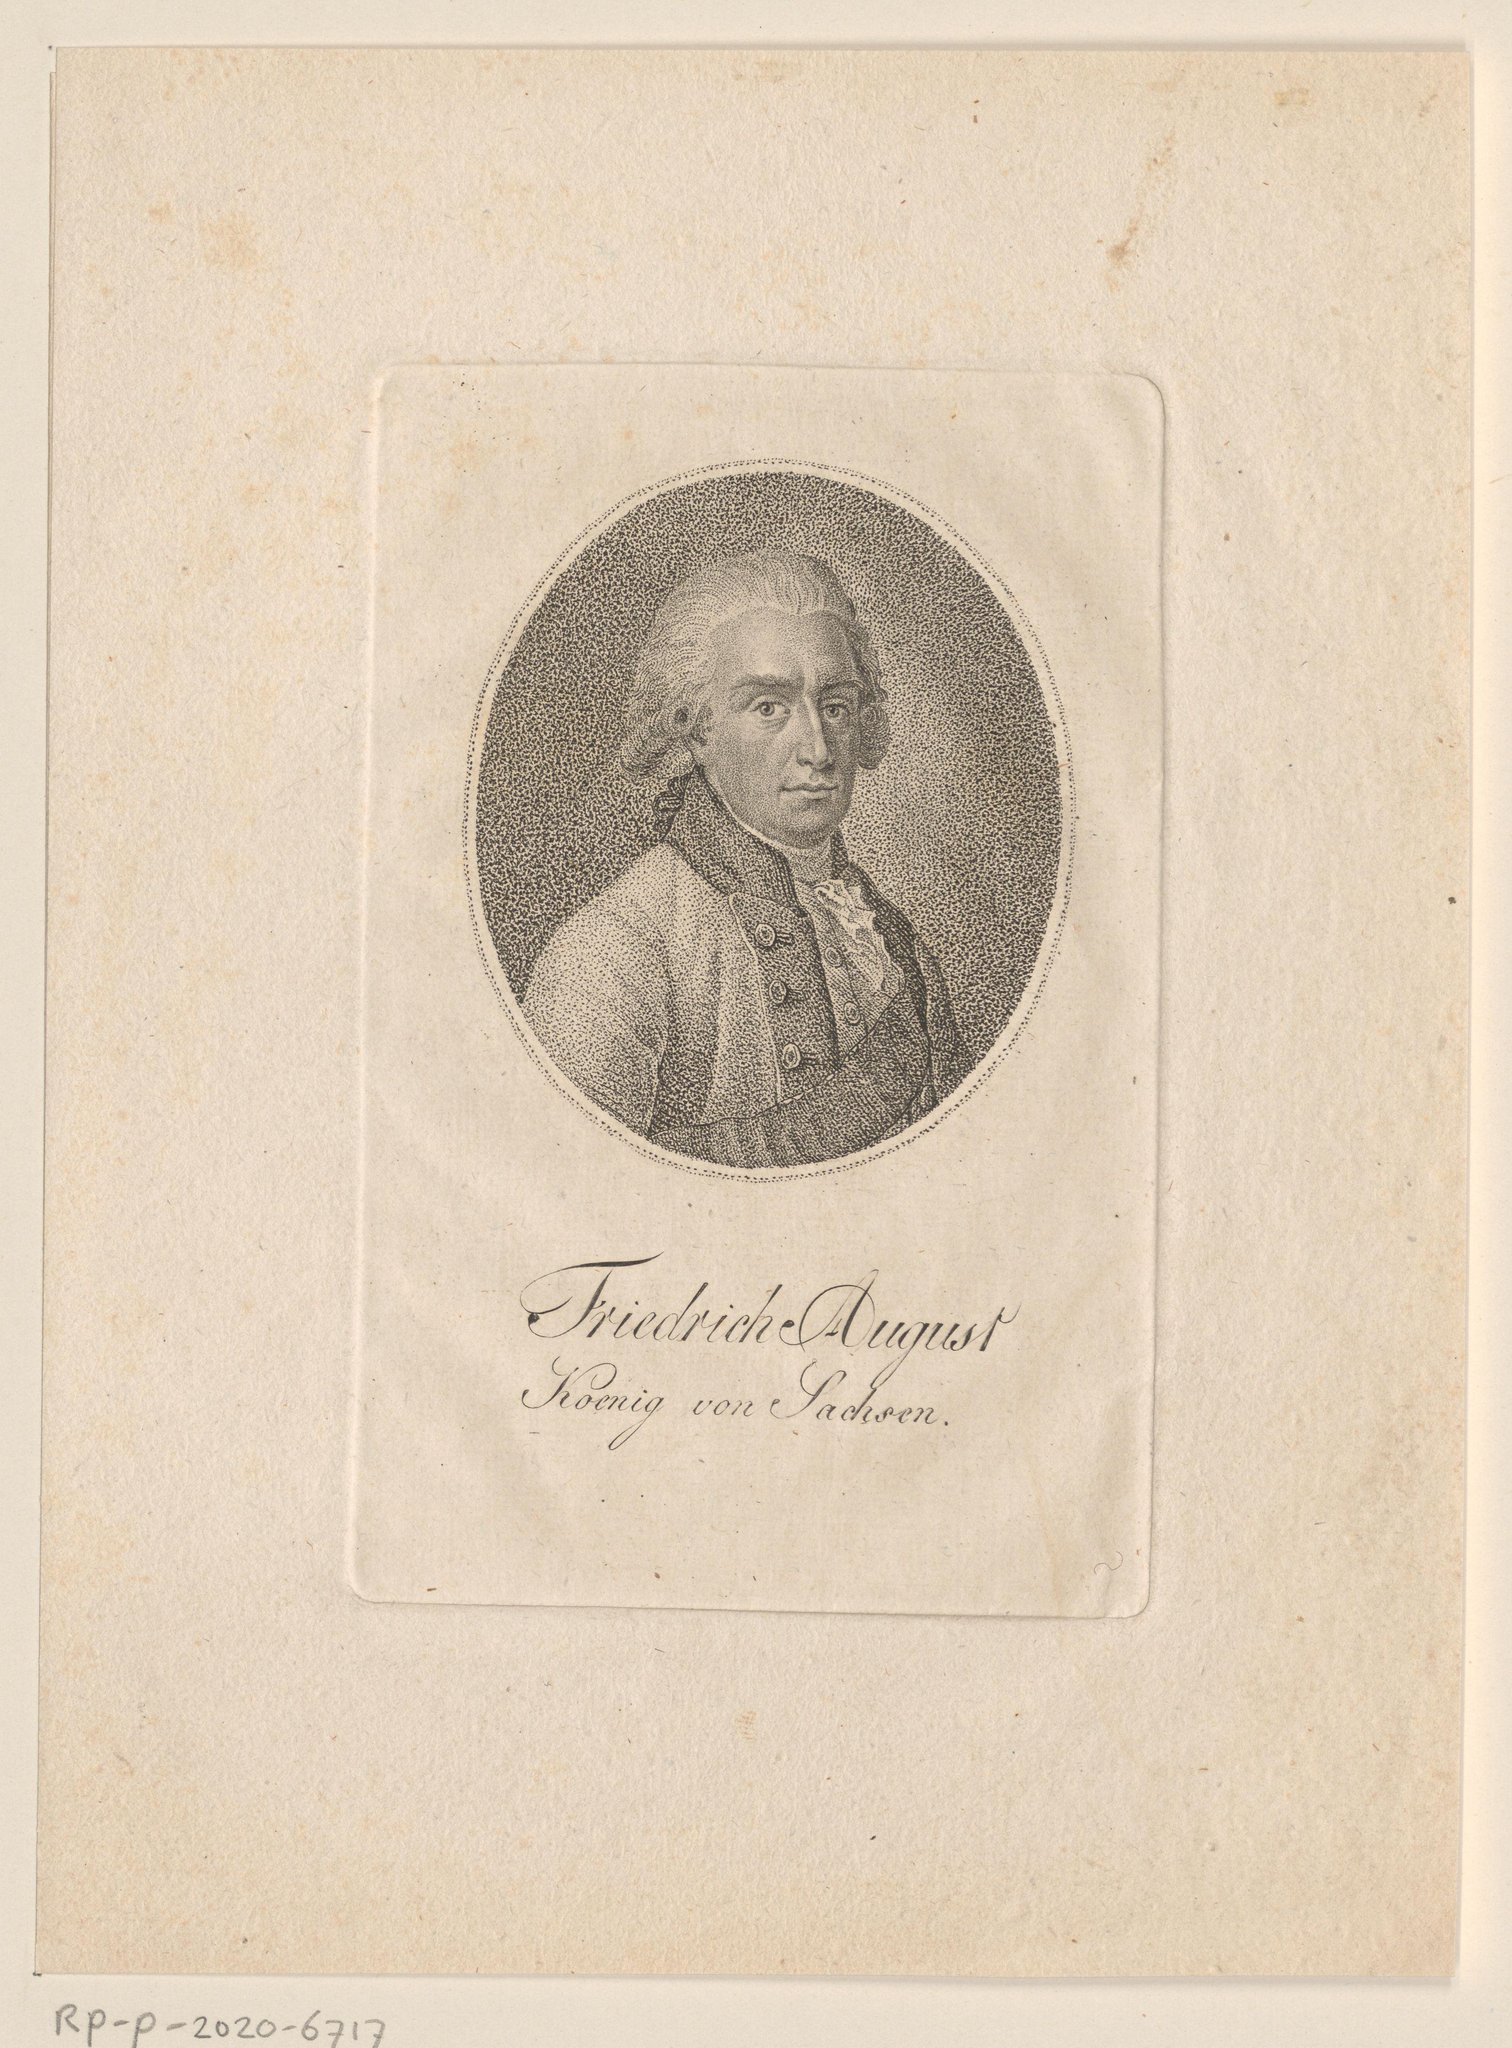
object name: print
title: Portret van Frederik August I van Saksen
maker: Anonymous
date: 1811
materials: paper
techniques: etching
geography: germany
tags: frederik august i (koning van saksen), historical persons, king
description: Prent waarschijnlijk uit: Pragmatische Geschichte der Europäischen Staaten seit dem Anfange der französischen Revolution bis auf unsere Zeit (...). Gotha: Carl Steudel, 1811, dl. 3.